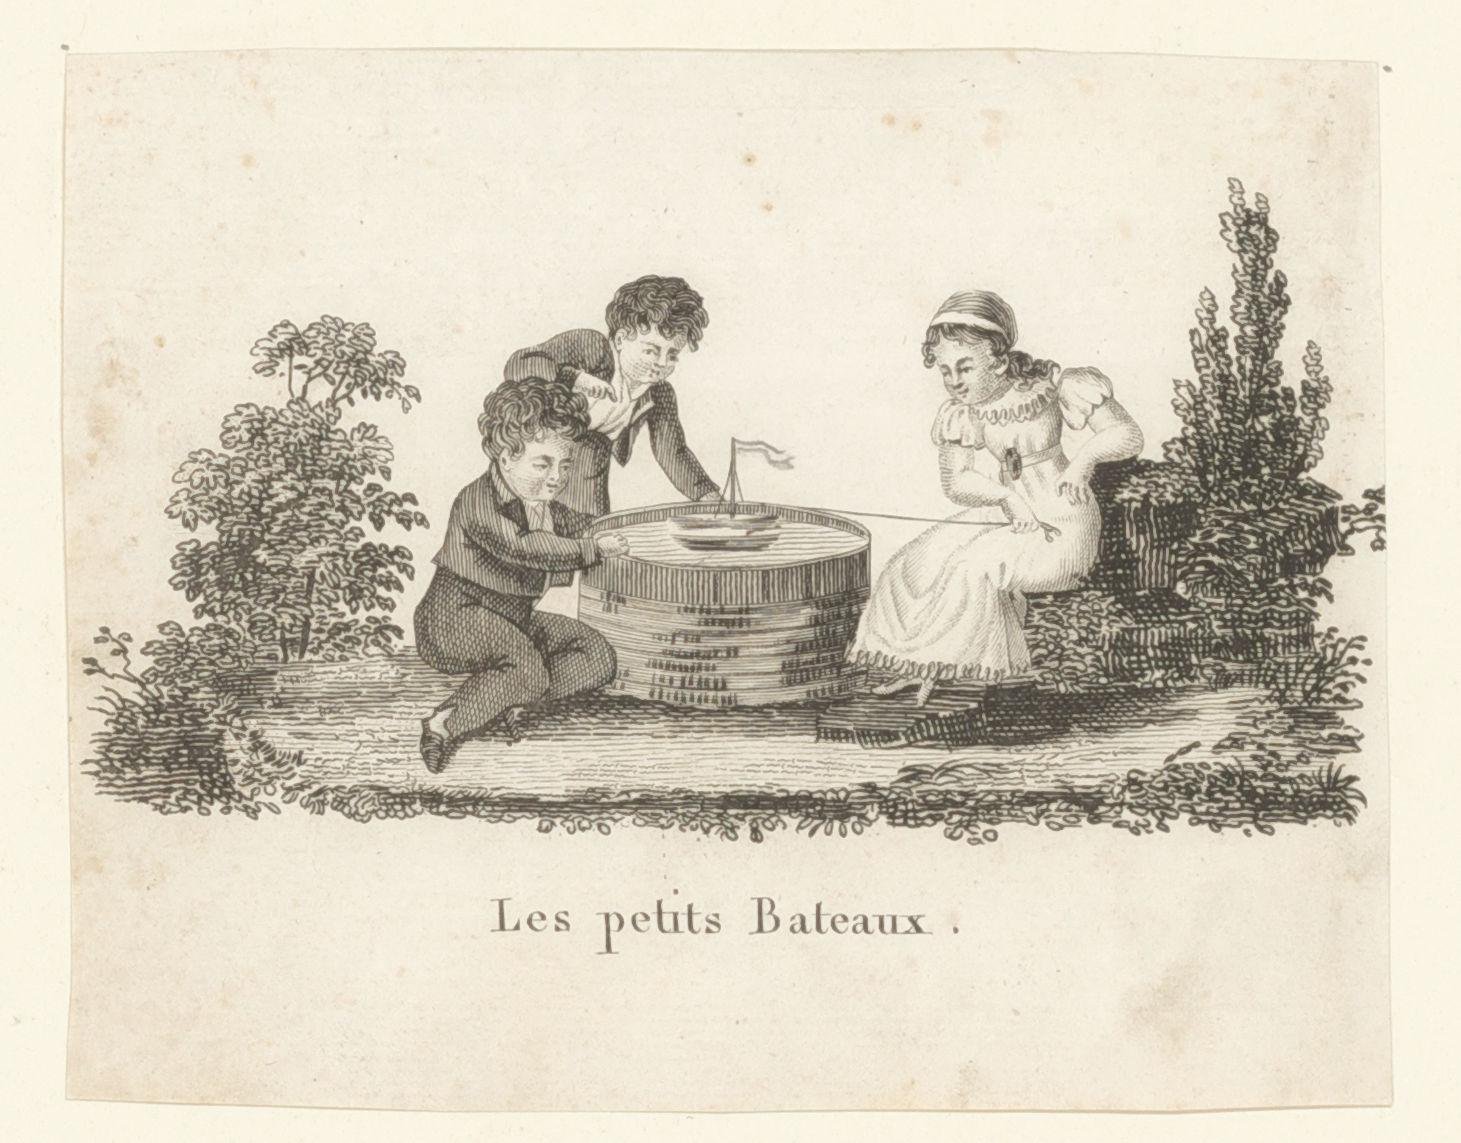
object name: print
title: Drie kinderen spelen met kleine zeilboot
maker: Anonymous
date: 1800-1899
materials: paper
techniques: etching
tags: children's games and plays, ships (in general)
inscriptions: stamp, collector's mark: Lugt 1641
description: Onderwerpsrubrieken binnen de Atlas Zeden en Gewoonten: Zeden en Gewoonten in Engeren Zin, Des menschen beging, midden en einde, Kinderleven – Kinderspel en Kinderprenten.